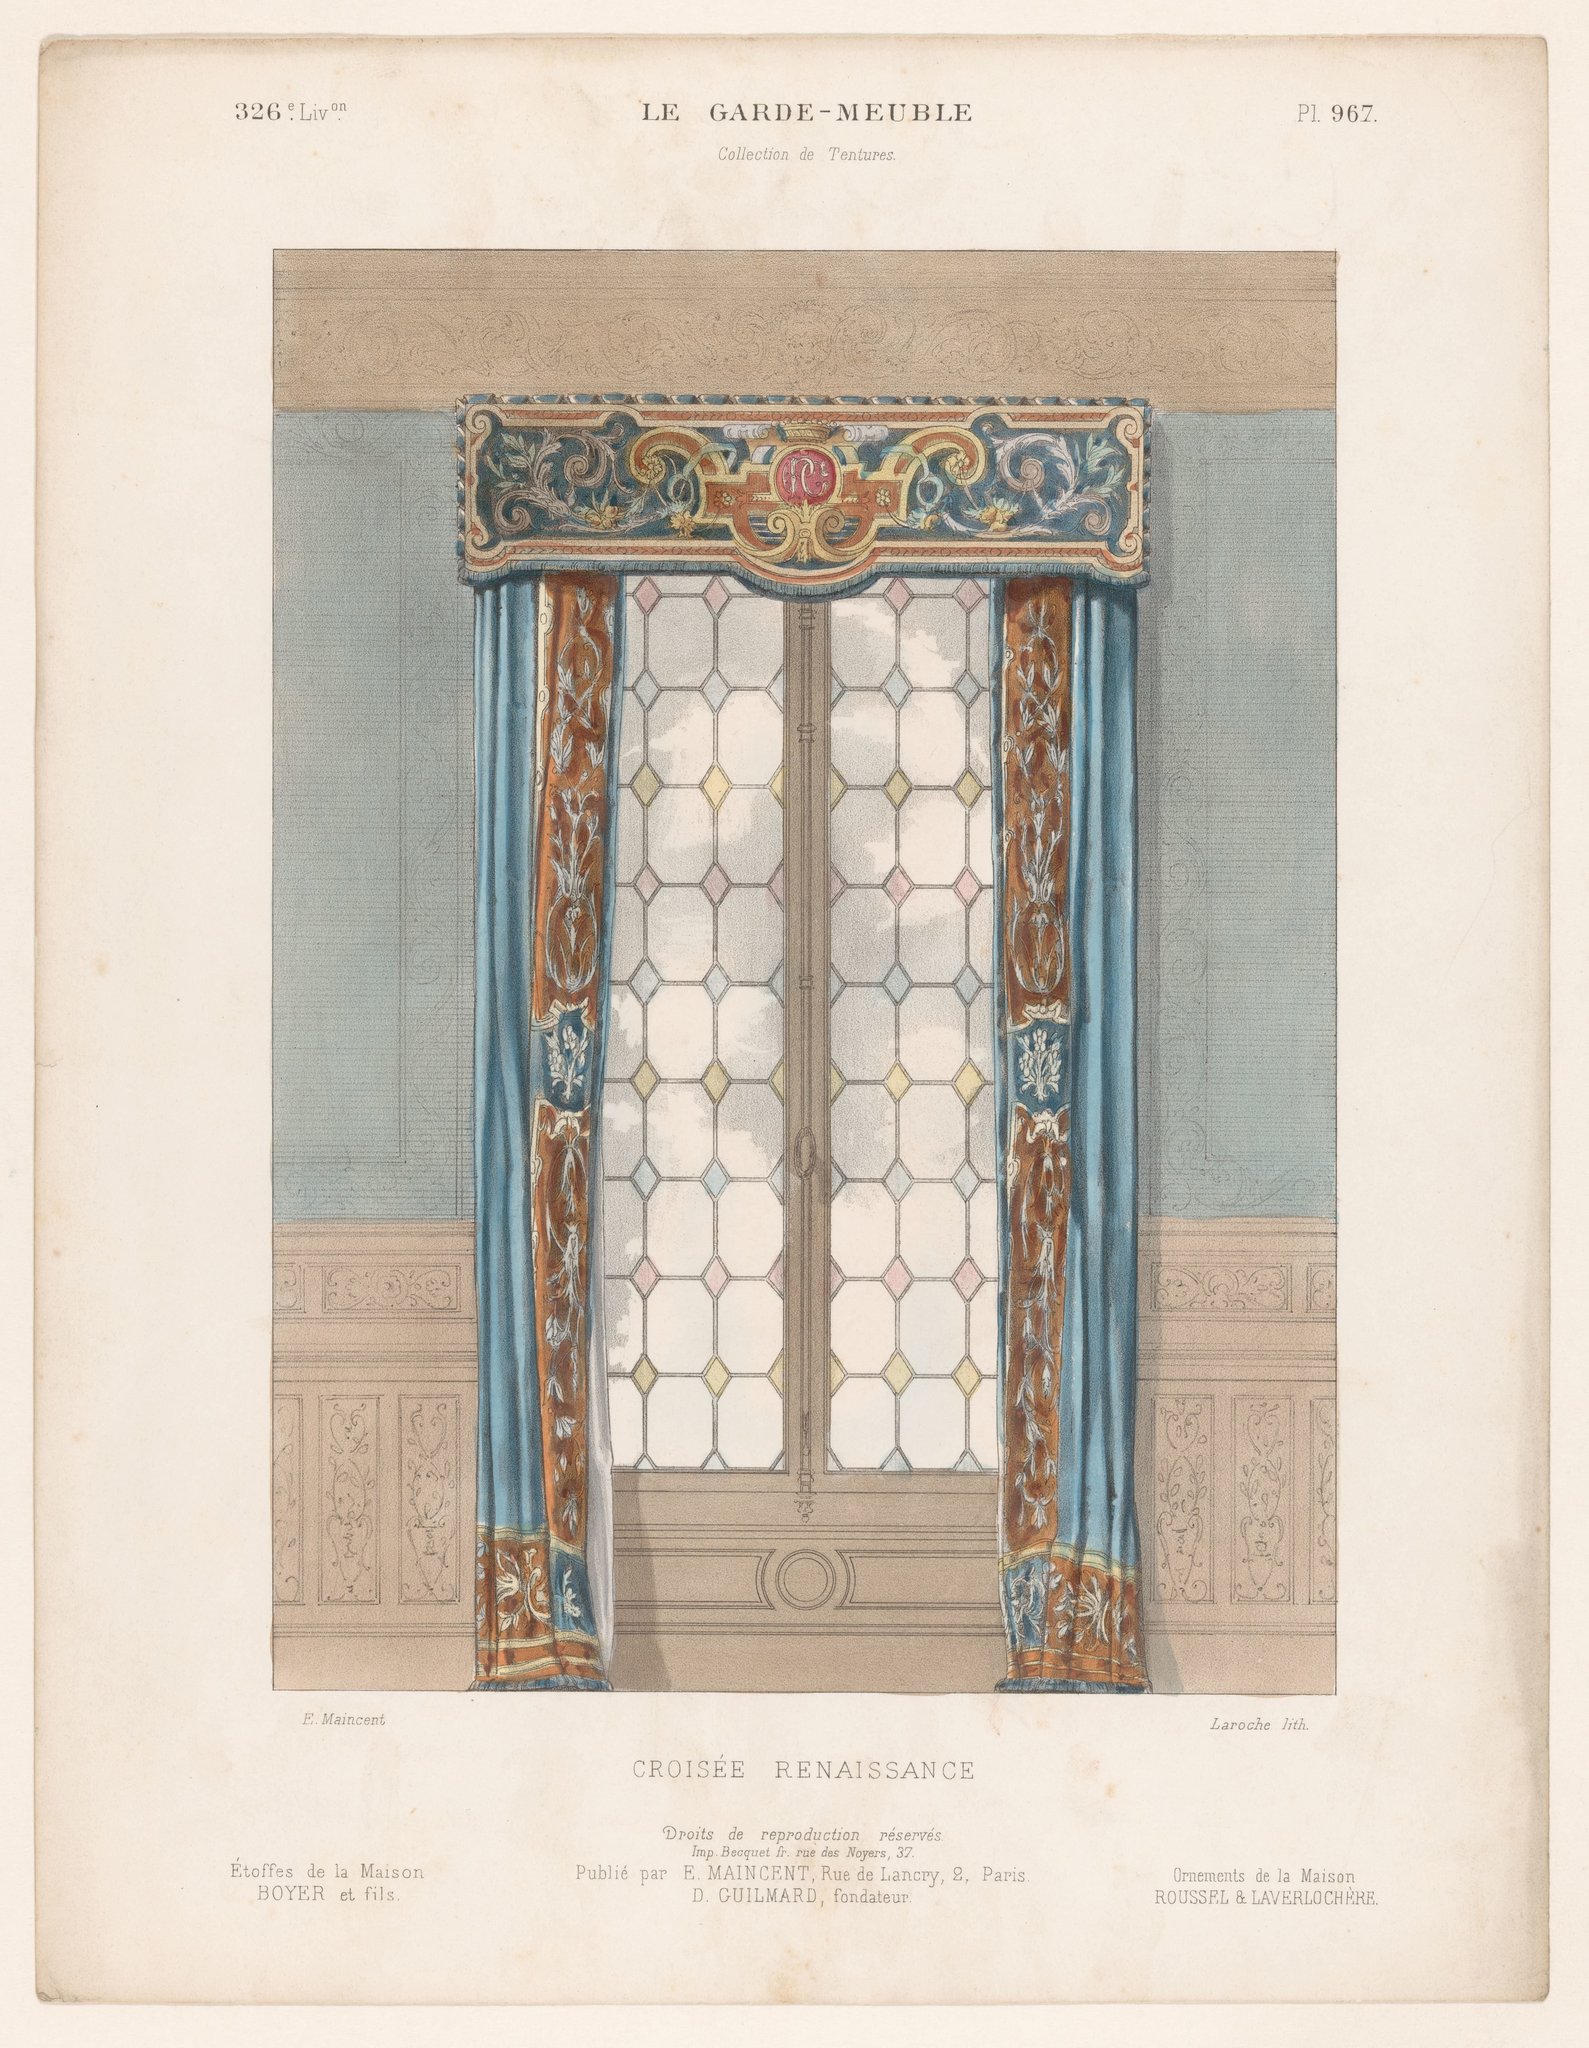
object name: print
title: Venster met gordijnen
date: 1885-1895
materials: paper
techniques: hand coloring, lithograph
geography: paris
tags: window, hangings and drapery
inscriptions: : ‘Droits de reproduction réservés.’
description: Kruisvenster met gedrapeerde gordijnen in renaissancestijl. Prent uit 326e Livraison.